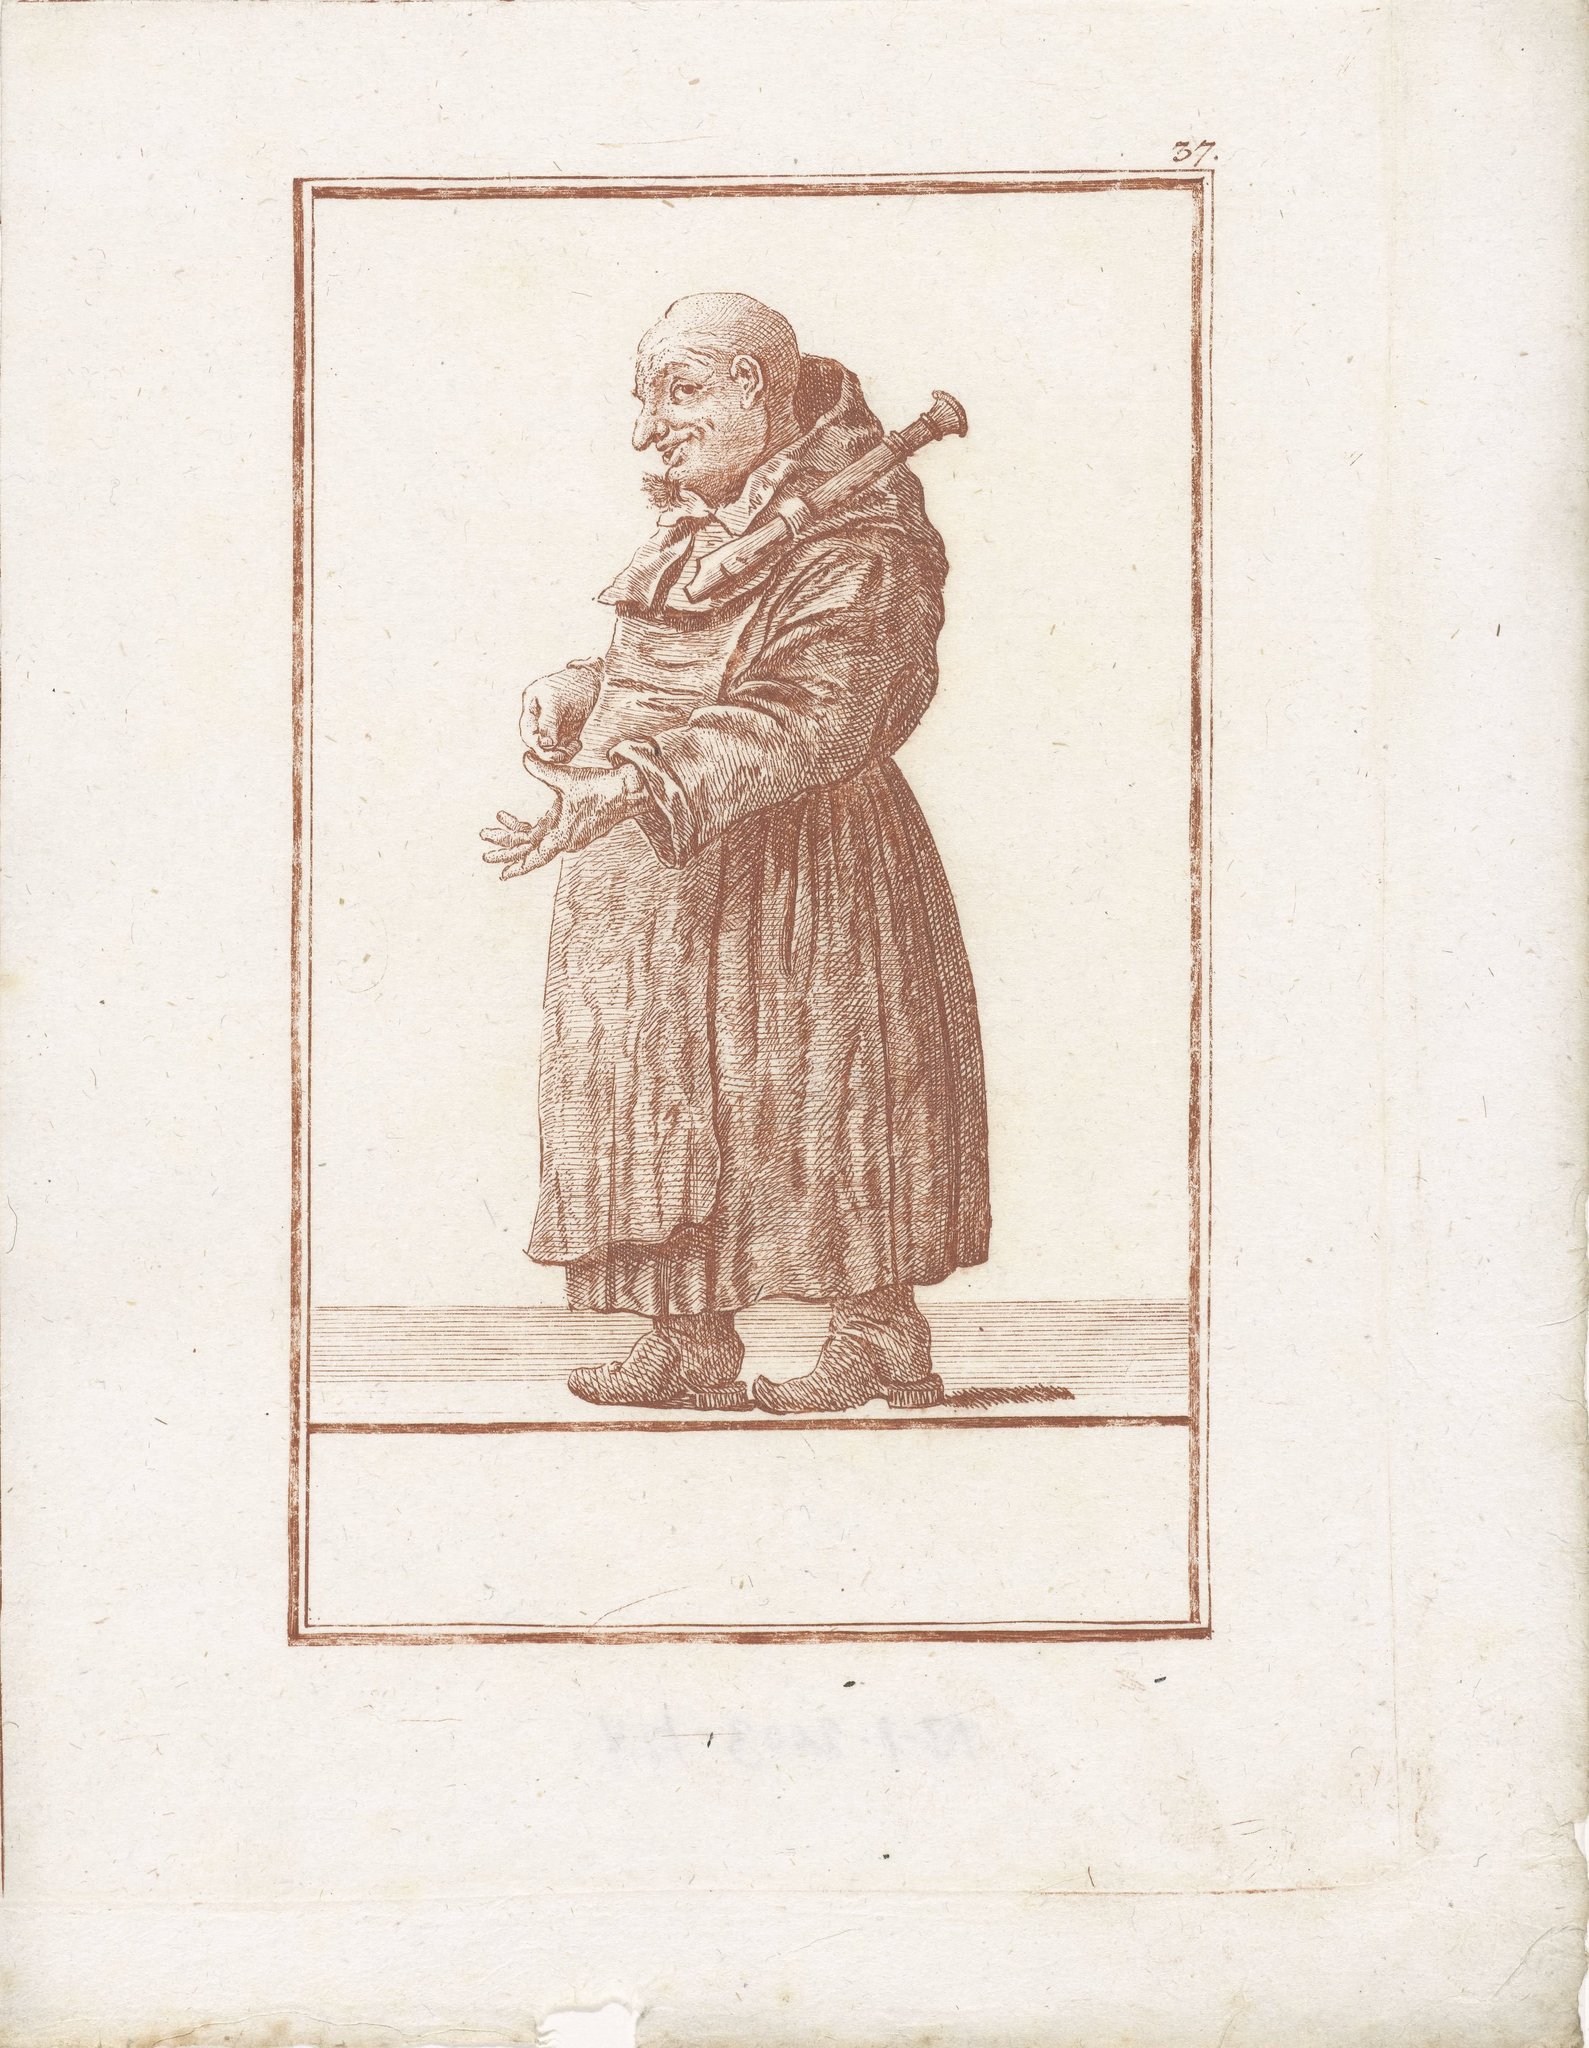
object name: print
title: L'Abregé du Faux Clerge Romain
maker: jacob gole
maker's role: print maker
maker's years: 1660-1724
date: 1724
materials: paper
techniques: etching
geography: amsterdam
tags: monk(s), friar(s), recorder (musical instrument), (aspects of) christian religion or the church (as institution) ridiculed, criticized, or caricaturized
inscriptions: collector's mark: Lugt 2760, collector's mark: Lugt 2228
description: Kale monnik met voorschoot over zijn pij. Op zijn linkerschouder is een blokfluit aan zijn pij vastgemaakt. De prent is deel van een 50-delige serie met als onderwerp de misbruiken van de katholieke geestelijkheid.